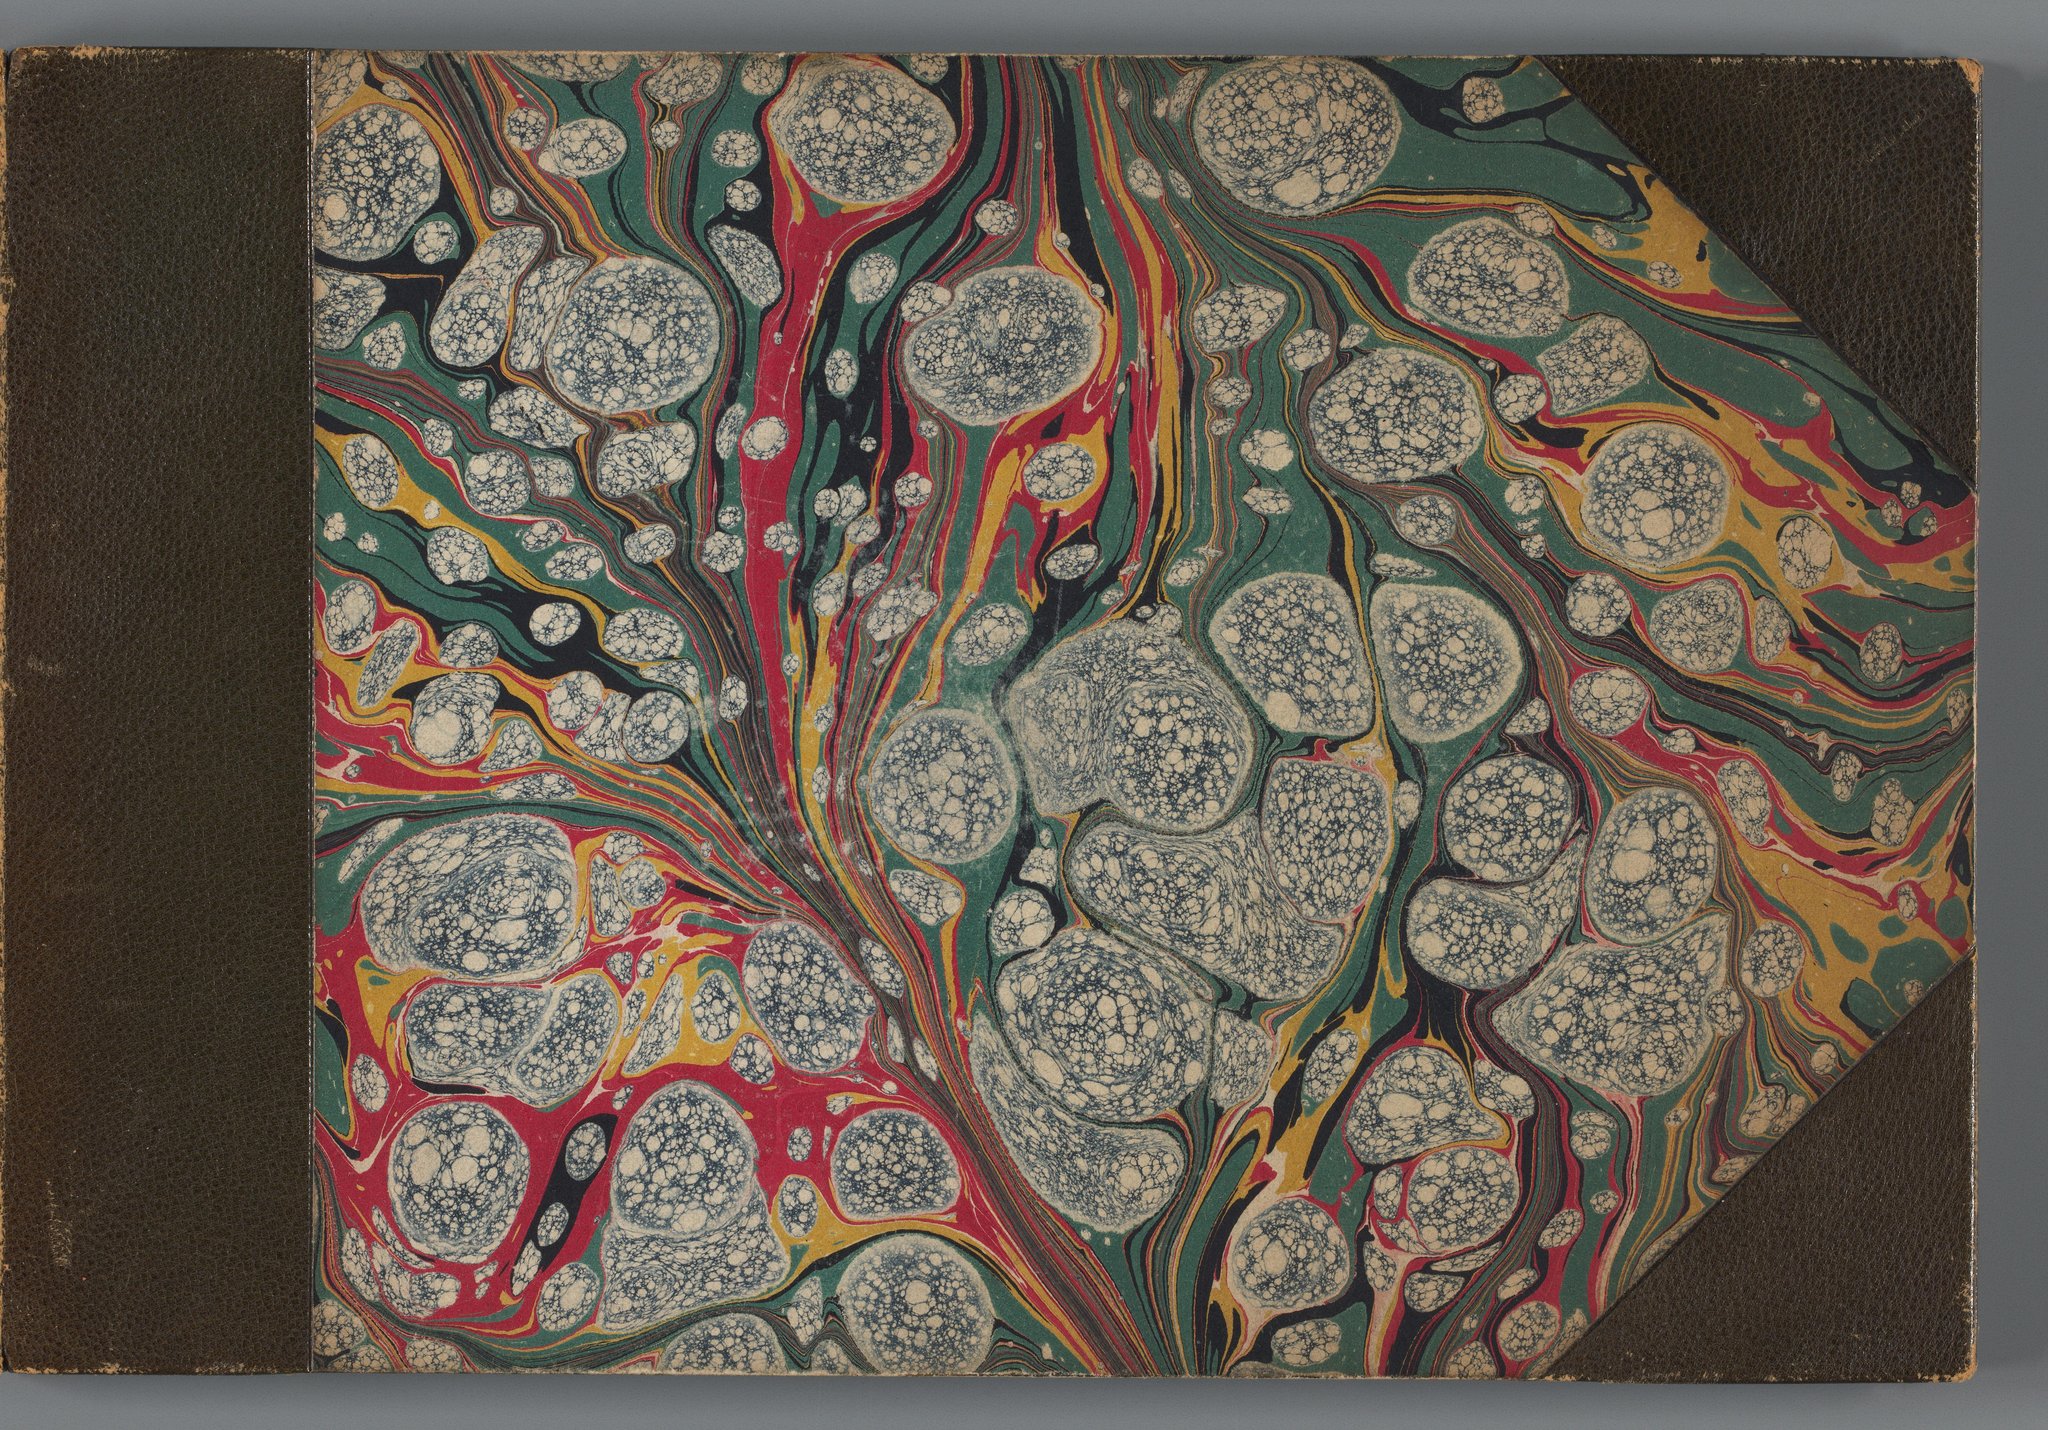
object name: prentrecueil, prentenalbum, prentalbum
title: A New Book of Ornaments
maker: p. baretti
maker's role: print maker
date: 1766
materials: leather, paper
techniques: bookbinding, engraving, marbling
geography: england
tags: ornaments ~ art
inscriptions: collector's mark: ‘Birmingham Assay Office Library’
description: Album met 16 ornamentele ontwerpen door P. Baretti. Ingebonden in latere band.